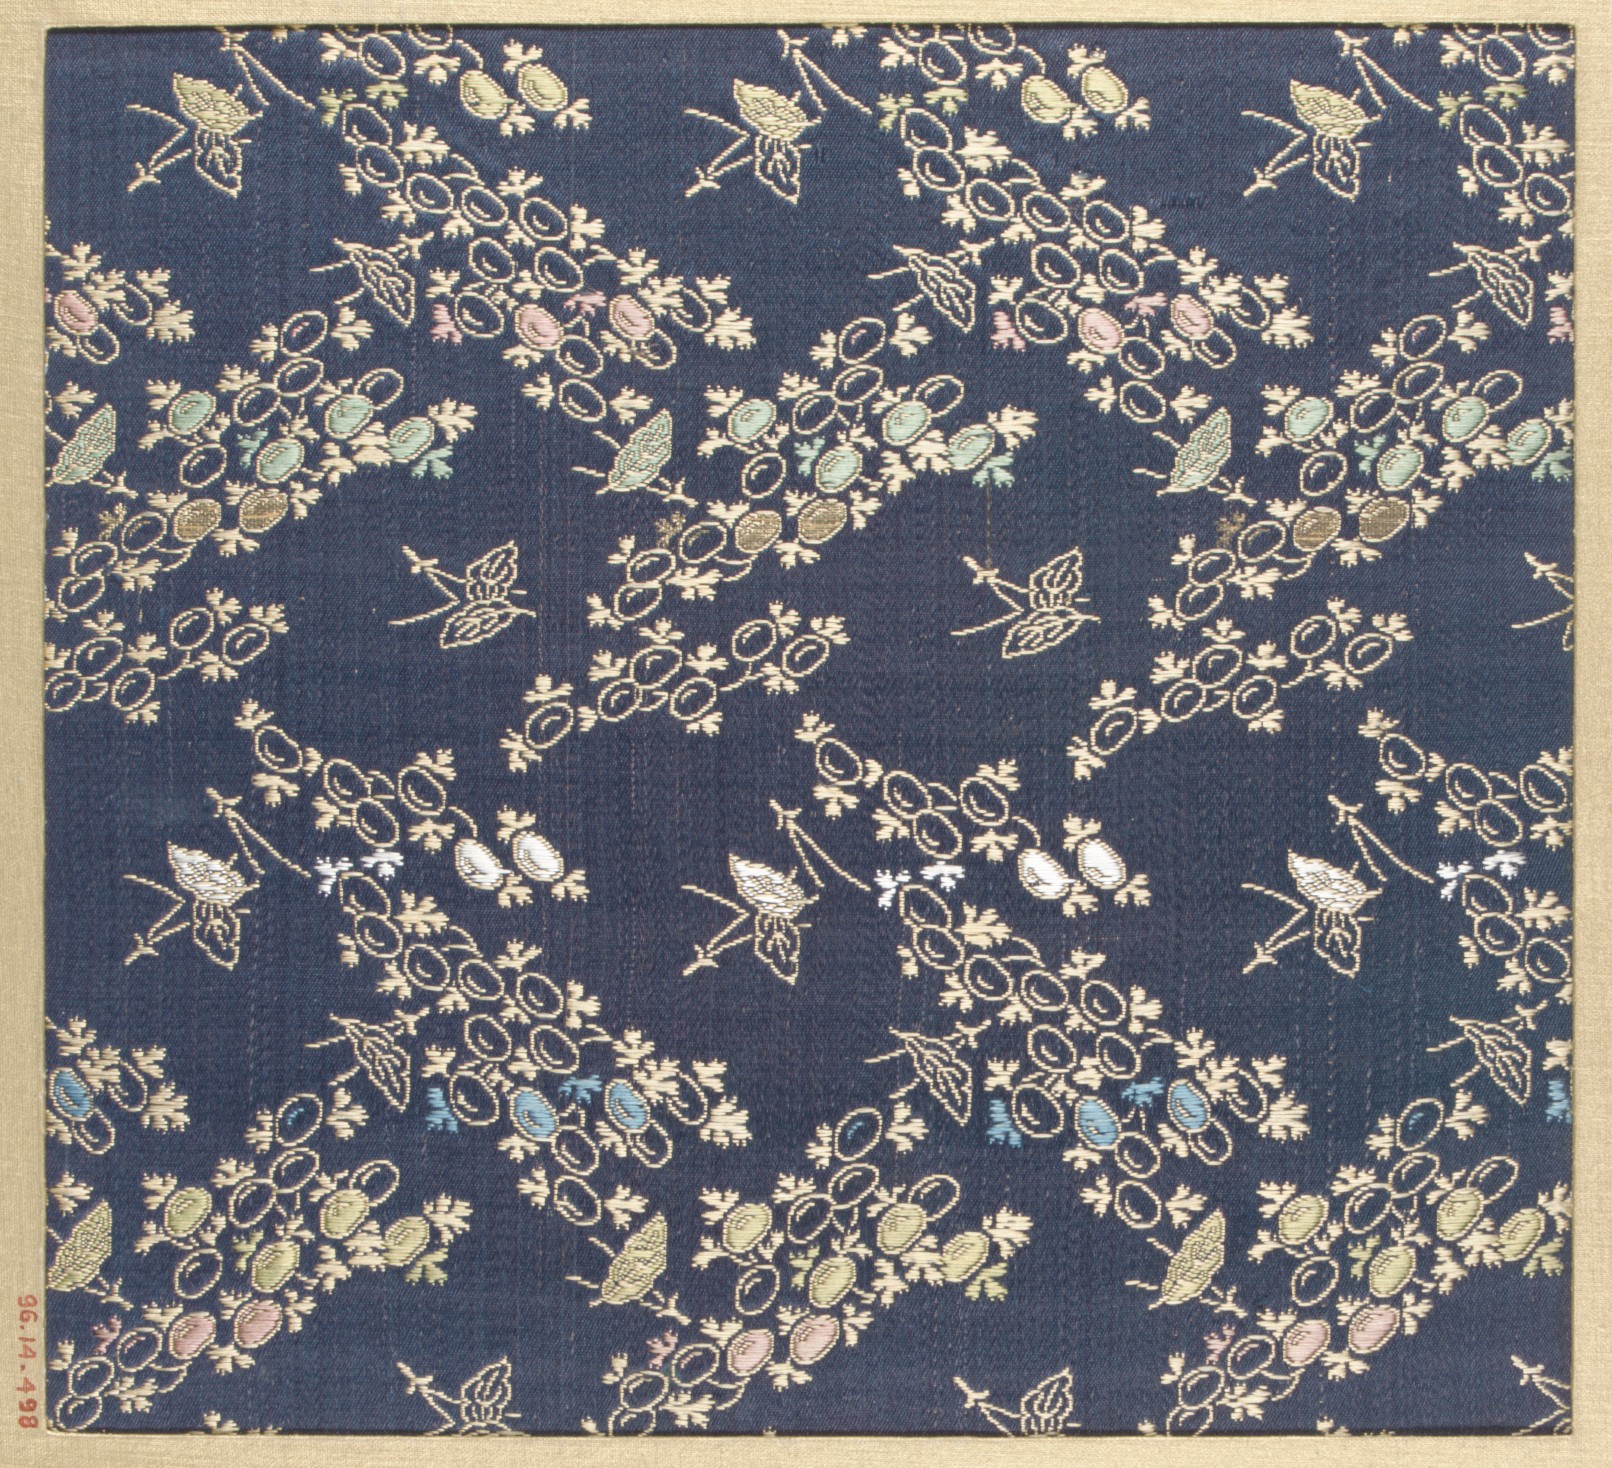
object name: piece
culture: japanese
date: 1701-1900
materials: silk